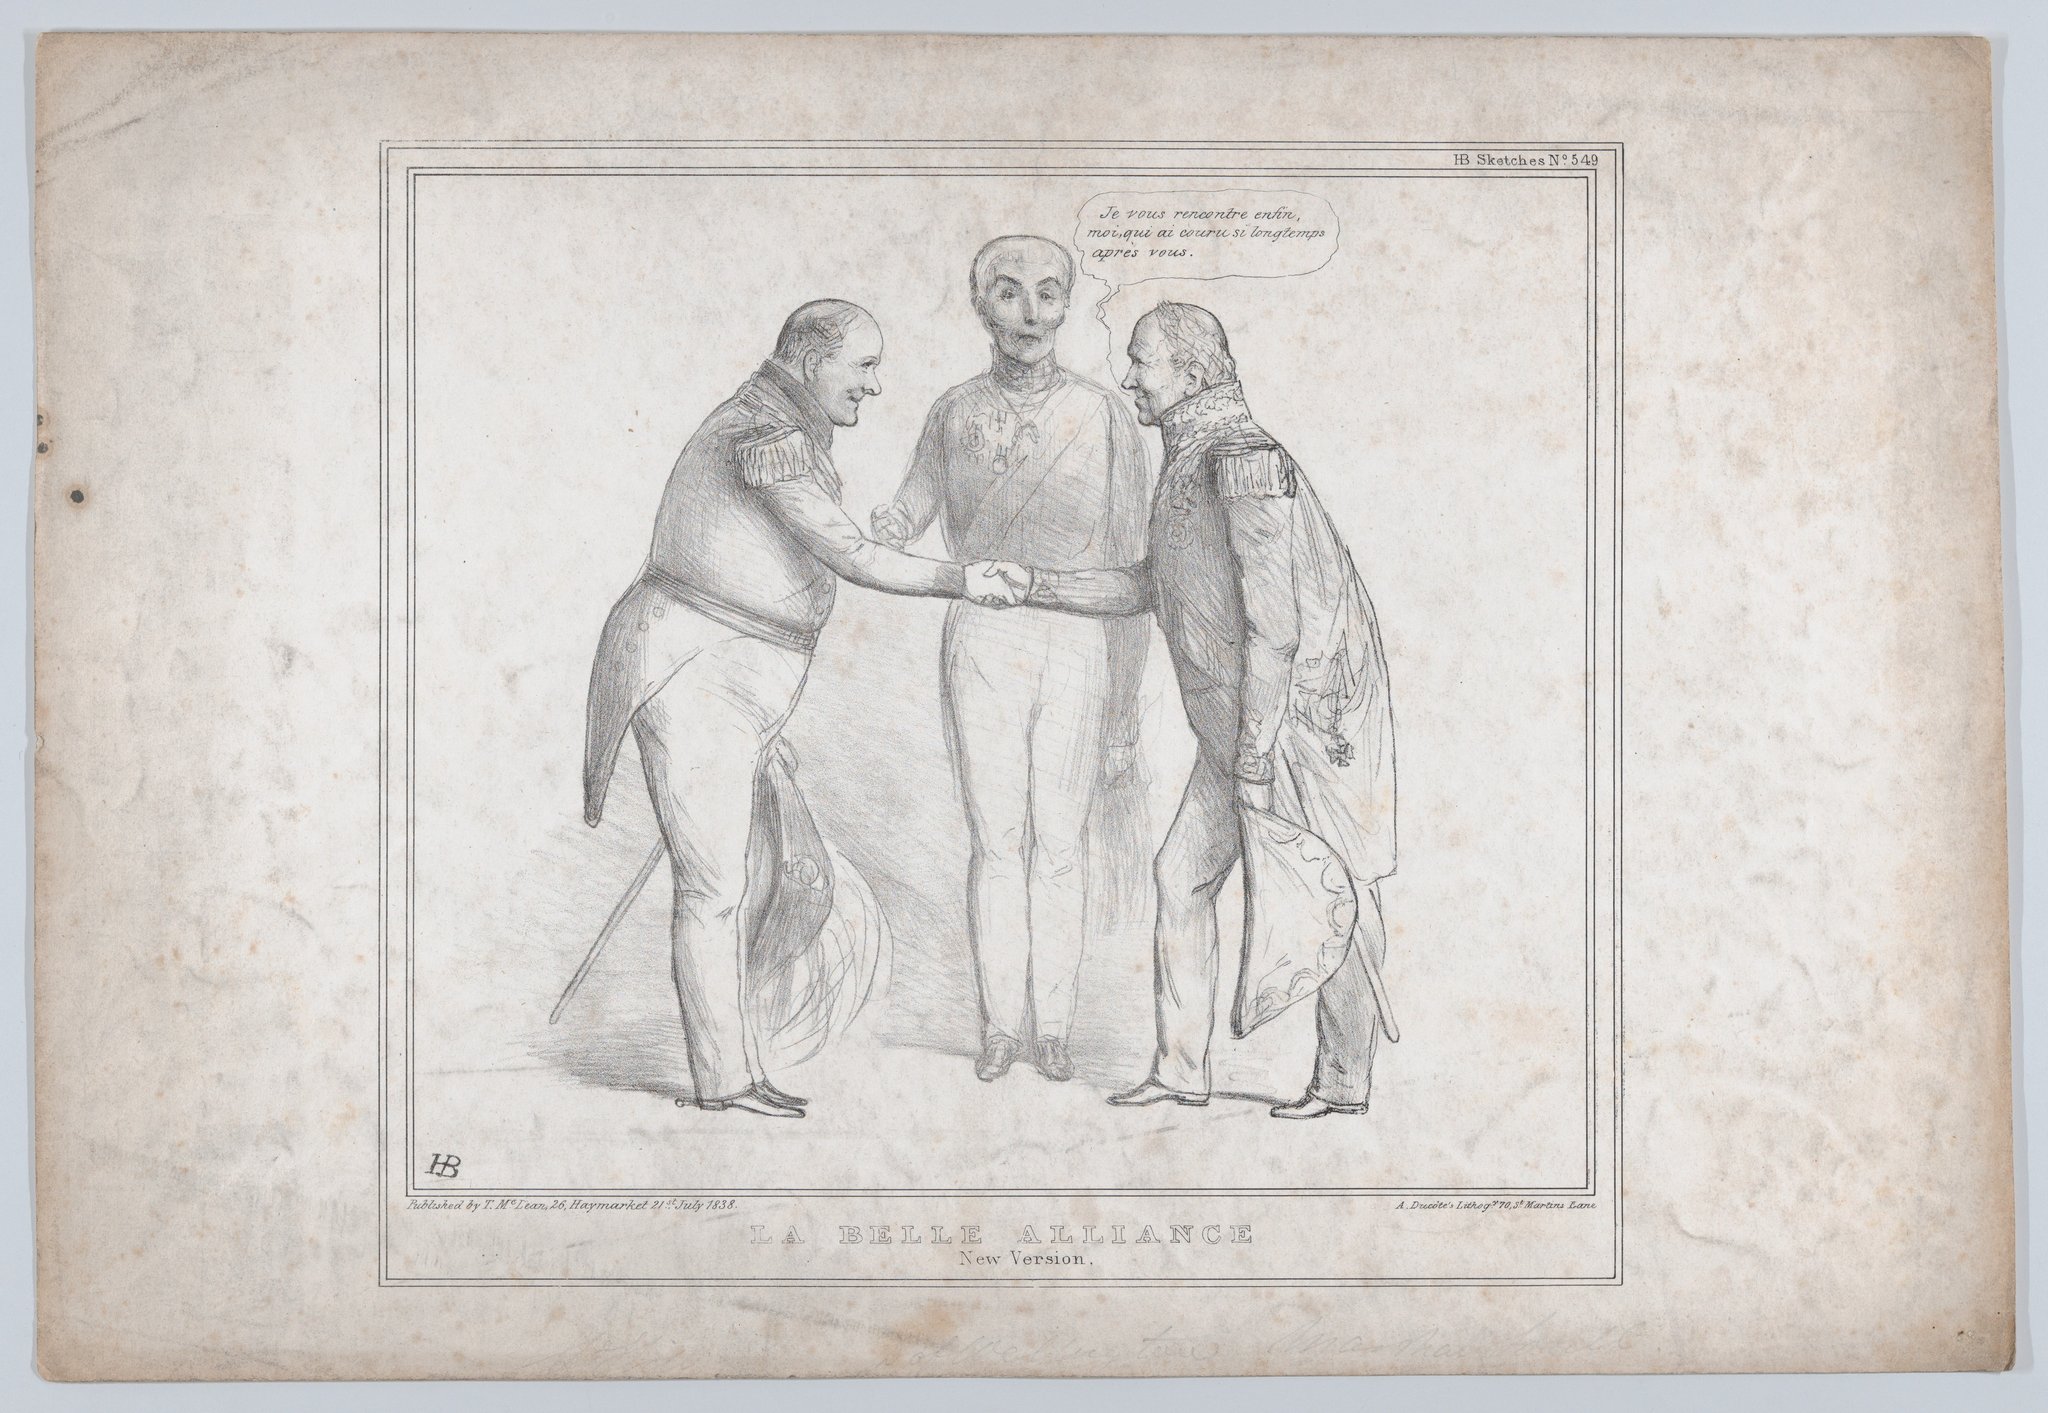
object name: print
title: La Belle Alliance: New Version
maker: john doyle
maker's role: artist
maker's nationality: irish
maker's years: 1797-1868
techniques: lithograph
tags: men